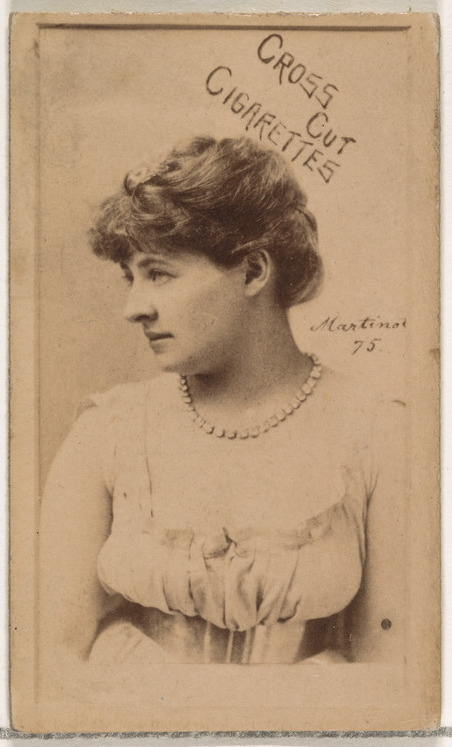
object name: print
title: Card Number 75, Sadie Martinot, from the Actors and Actresses series (N145-1) issued by Duke Sons & Co. to promote Cross Cut Cigarettes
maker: w. duke, sons & co.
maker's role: publisher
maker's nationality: american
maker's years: 1870-1920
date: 1880-1889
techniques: albumen silver print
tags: women,actresses